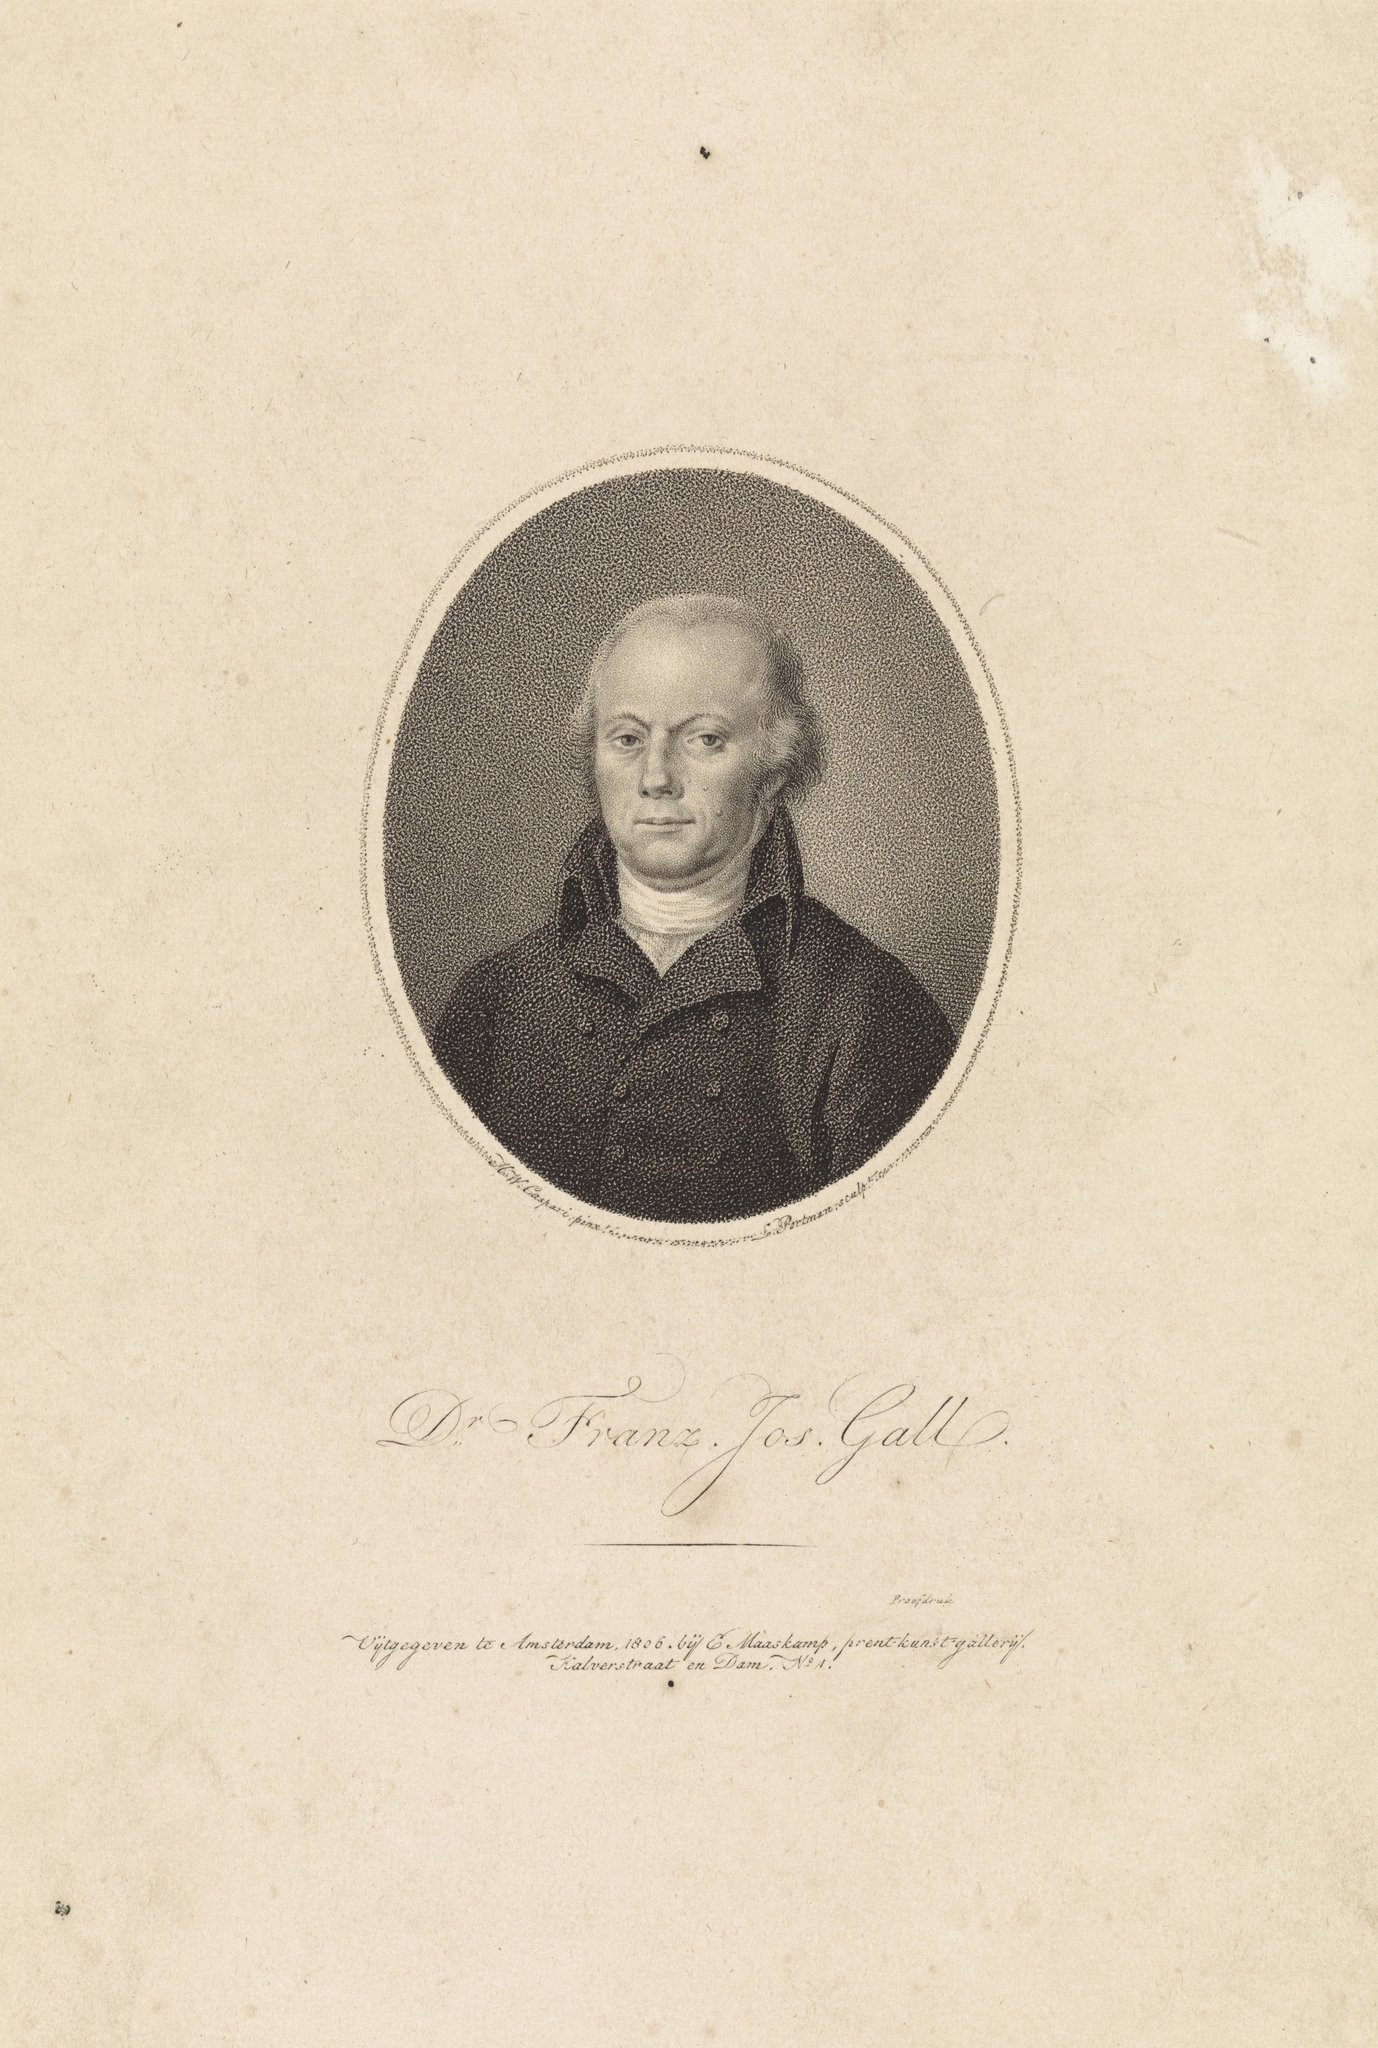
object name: print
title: Portret van fysioloog Franz Josef Gall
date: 1806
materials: paper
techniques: stippled etching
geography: amsterdam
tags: pforzheim, montrouge, franz joseph gall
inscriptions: collector's mark: Lugt 2228